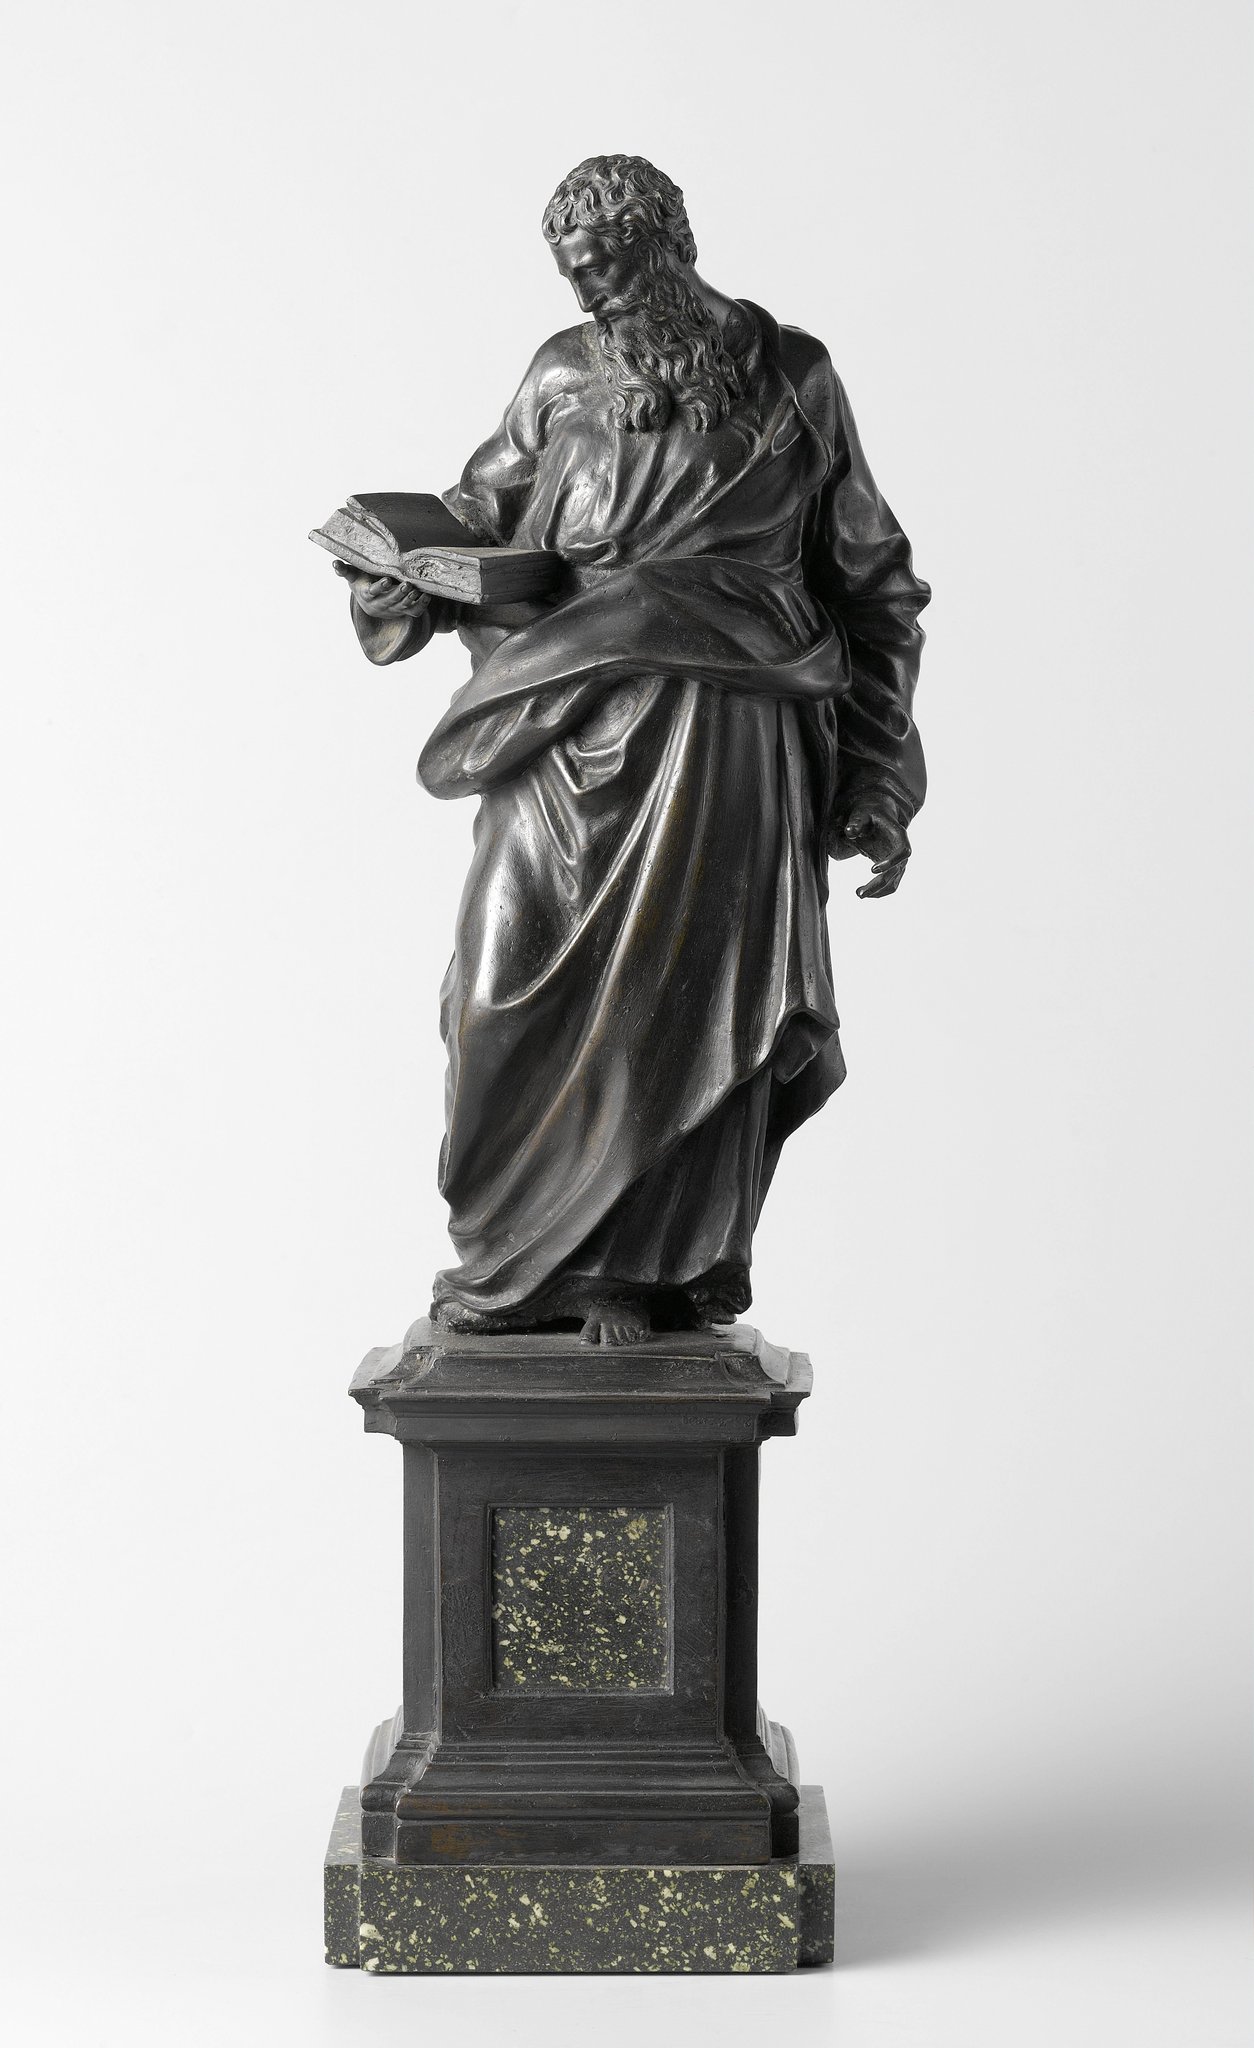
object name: sculpture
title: Paulus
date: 1600-1650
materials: bronze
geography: rome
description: Peter and Paul. Bronze, green and white mottled marble. Rome (?), c. 1600 - 1640.